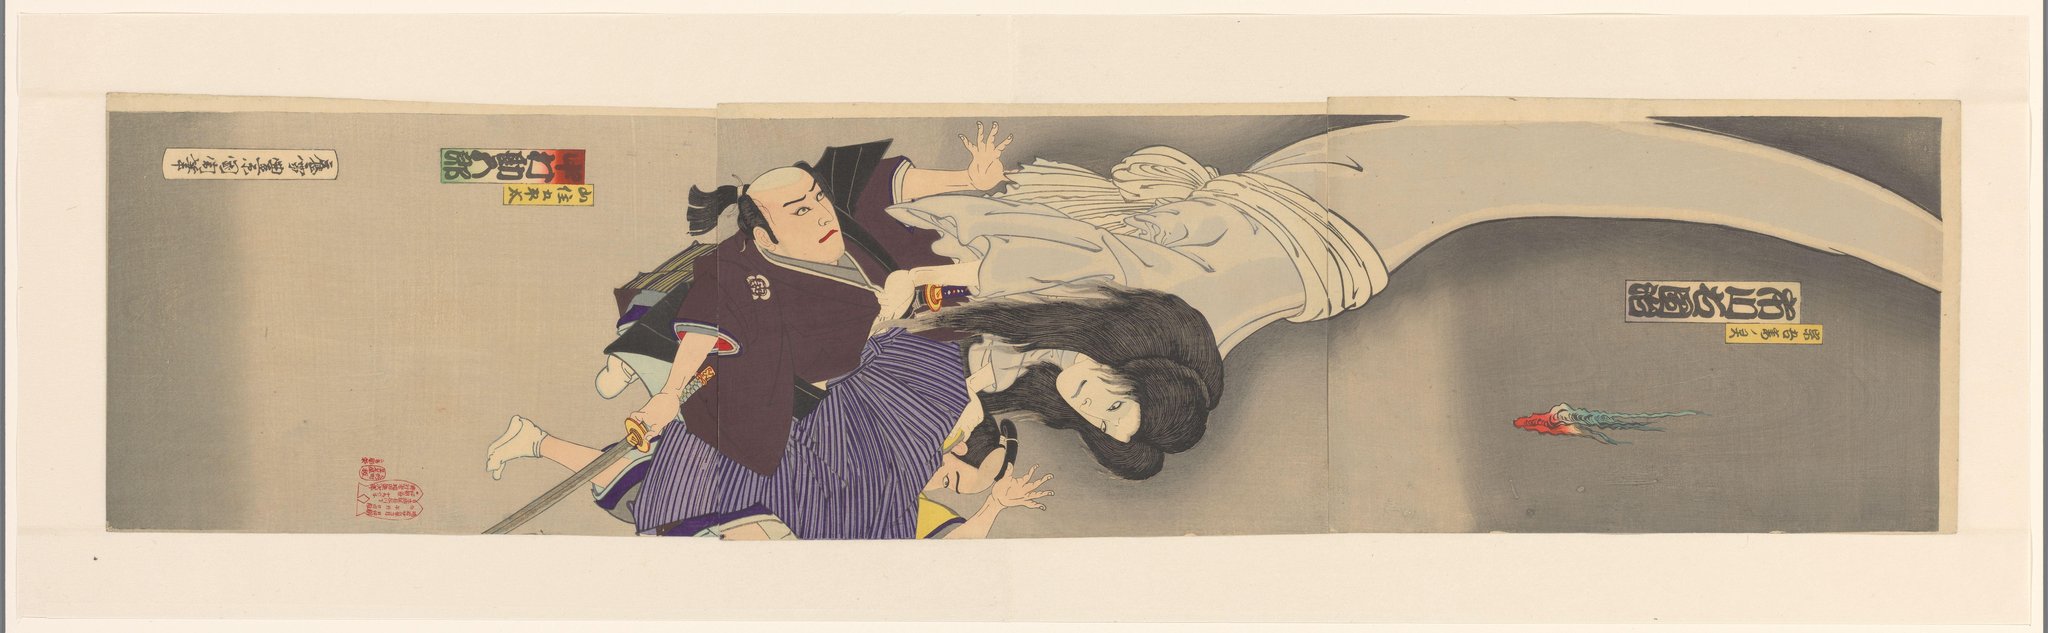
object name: print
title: Het spook van Sakura no Kiuchi Sogoro Ichikawa Udanji wreekt zich op krijgers van de Shogun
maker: toyohara kunichika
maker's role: print maker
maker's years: 1835-1900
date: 1893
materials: paper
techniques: woodcut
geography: edo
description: Verticaal triptiek met vrouwelijk spook dat twee krijgers belaagt.